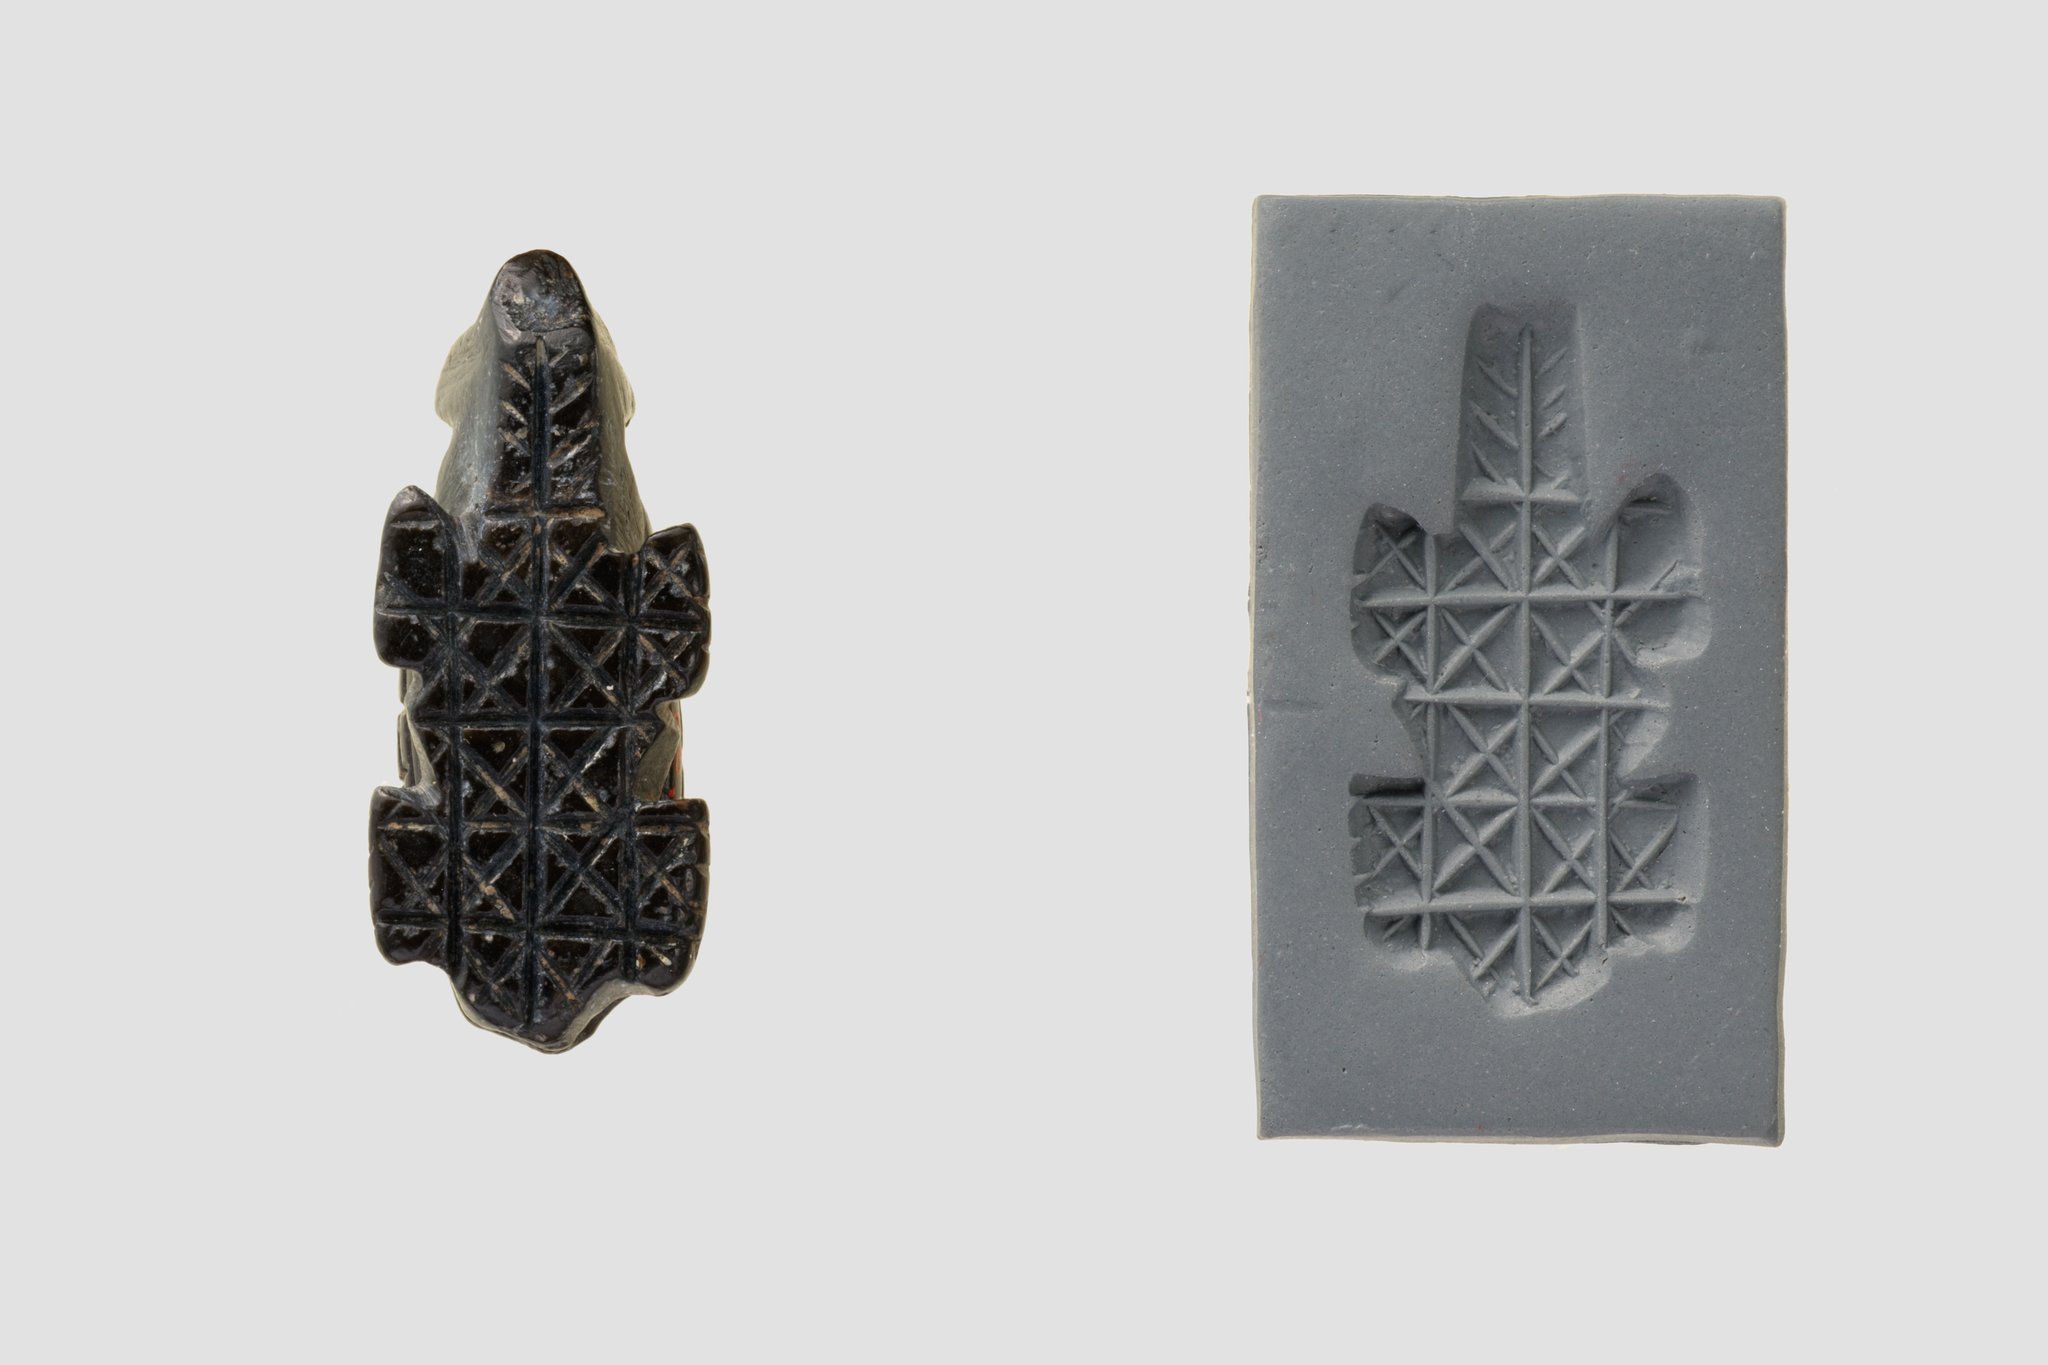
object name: stamp seal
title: Stamp seal and modern impression: geometric pattern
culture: halaf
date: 5600-5000 BCE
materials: mineral, stone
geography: northern mesopotamia or syria